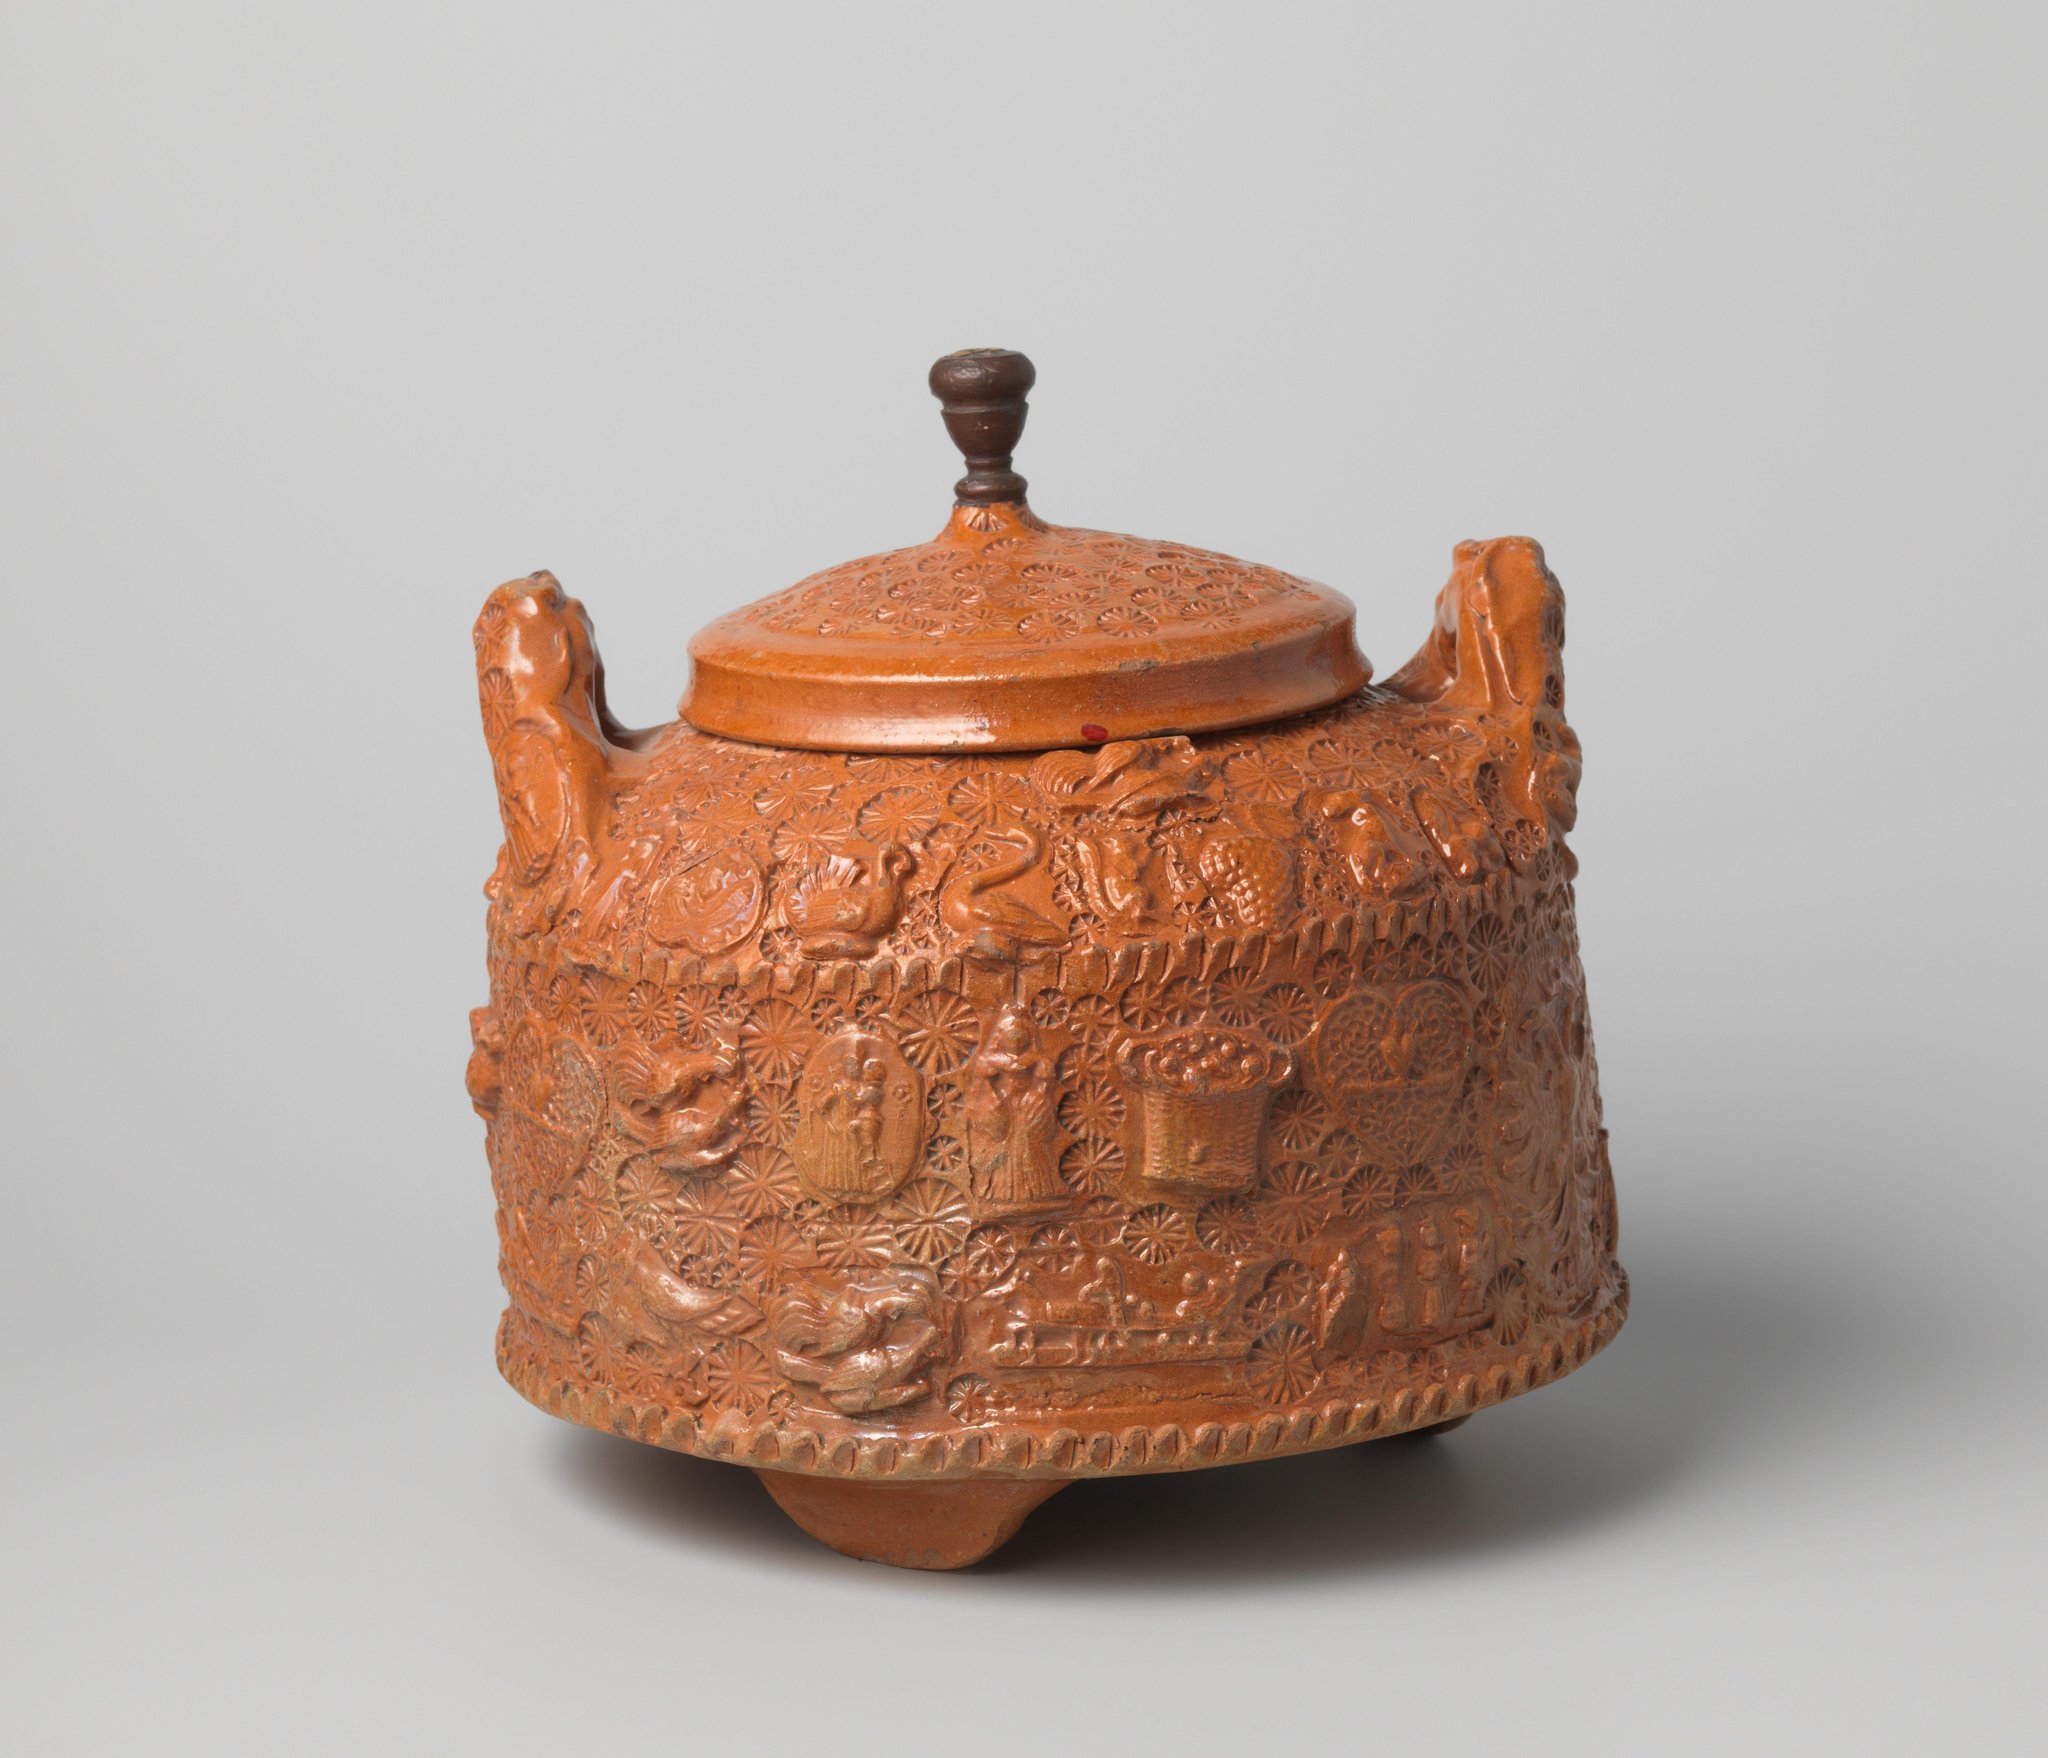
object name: pot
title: Doofpot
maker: Anonymous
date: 1650-1780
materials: earthenware, glaze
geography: netherlands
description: Doofpot van loodglazuuraardewerk, met deksel. De pot staat op drie poten en heeft twee oren. De pot is rijk geornamenteerd met menselijke figuren, dieren en wapens in relief, waartussen ingedrukte rozetten. Het deksel heeft een knop en is gedecoreerd met ingedrukte rozetten.